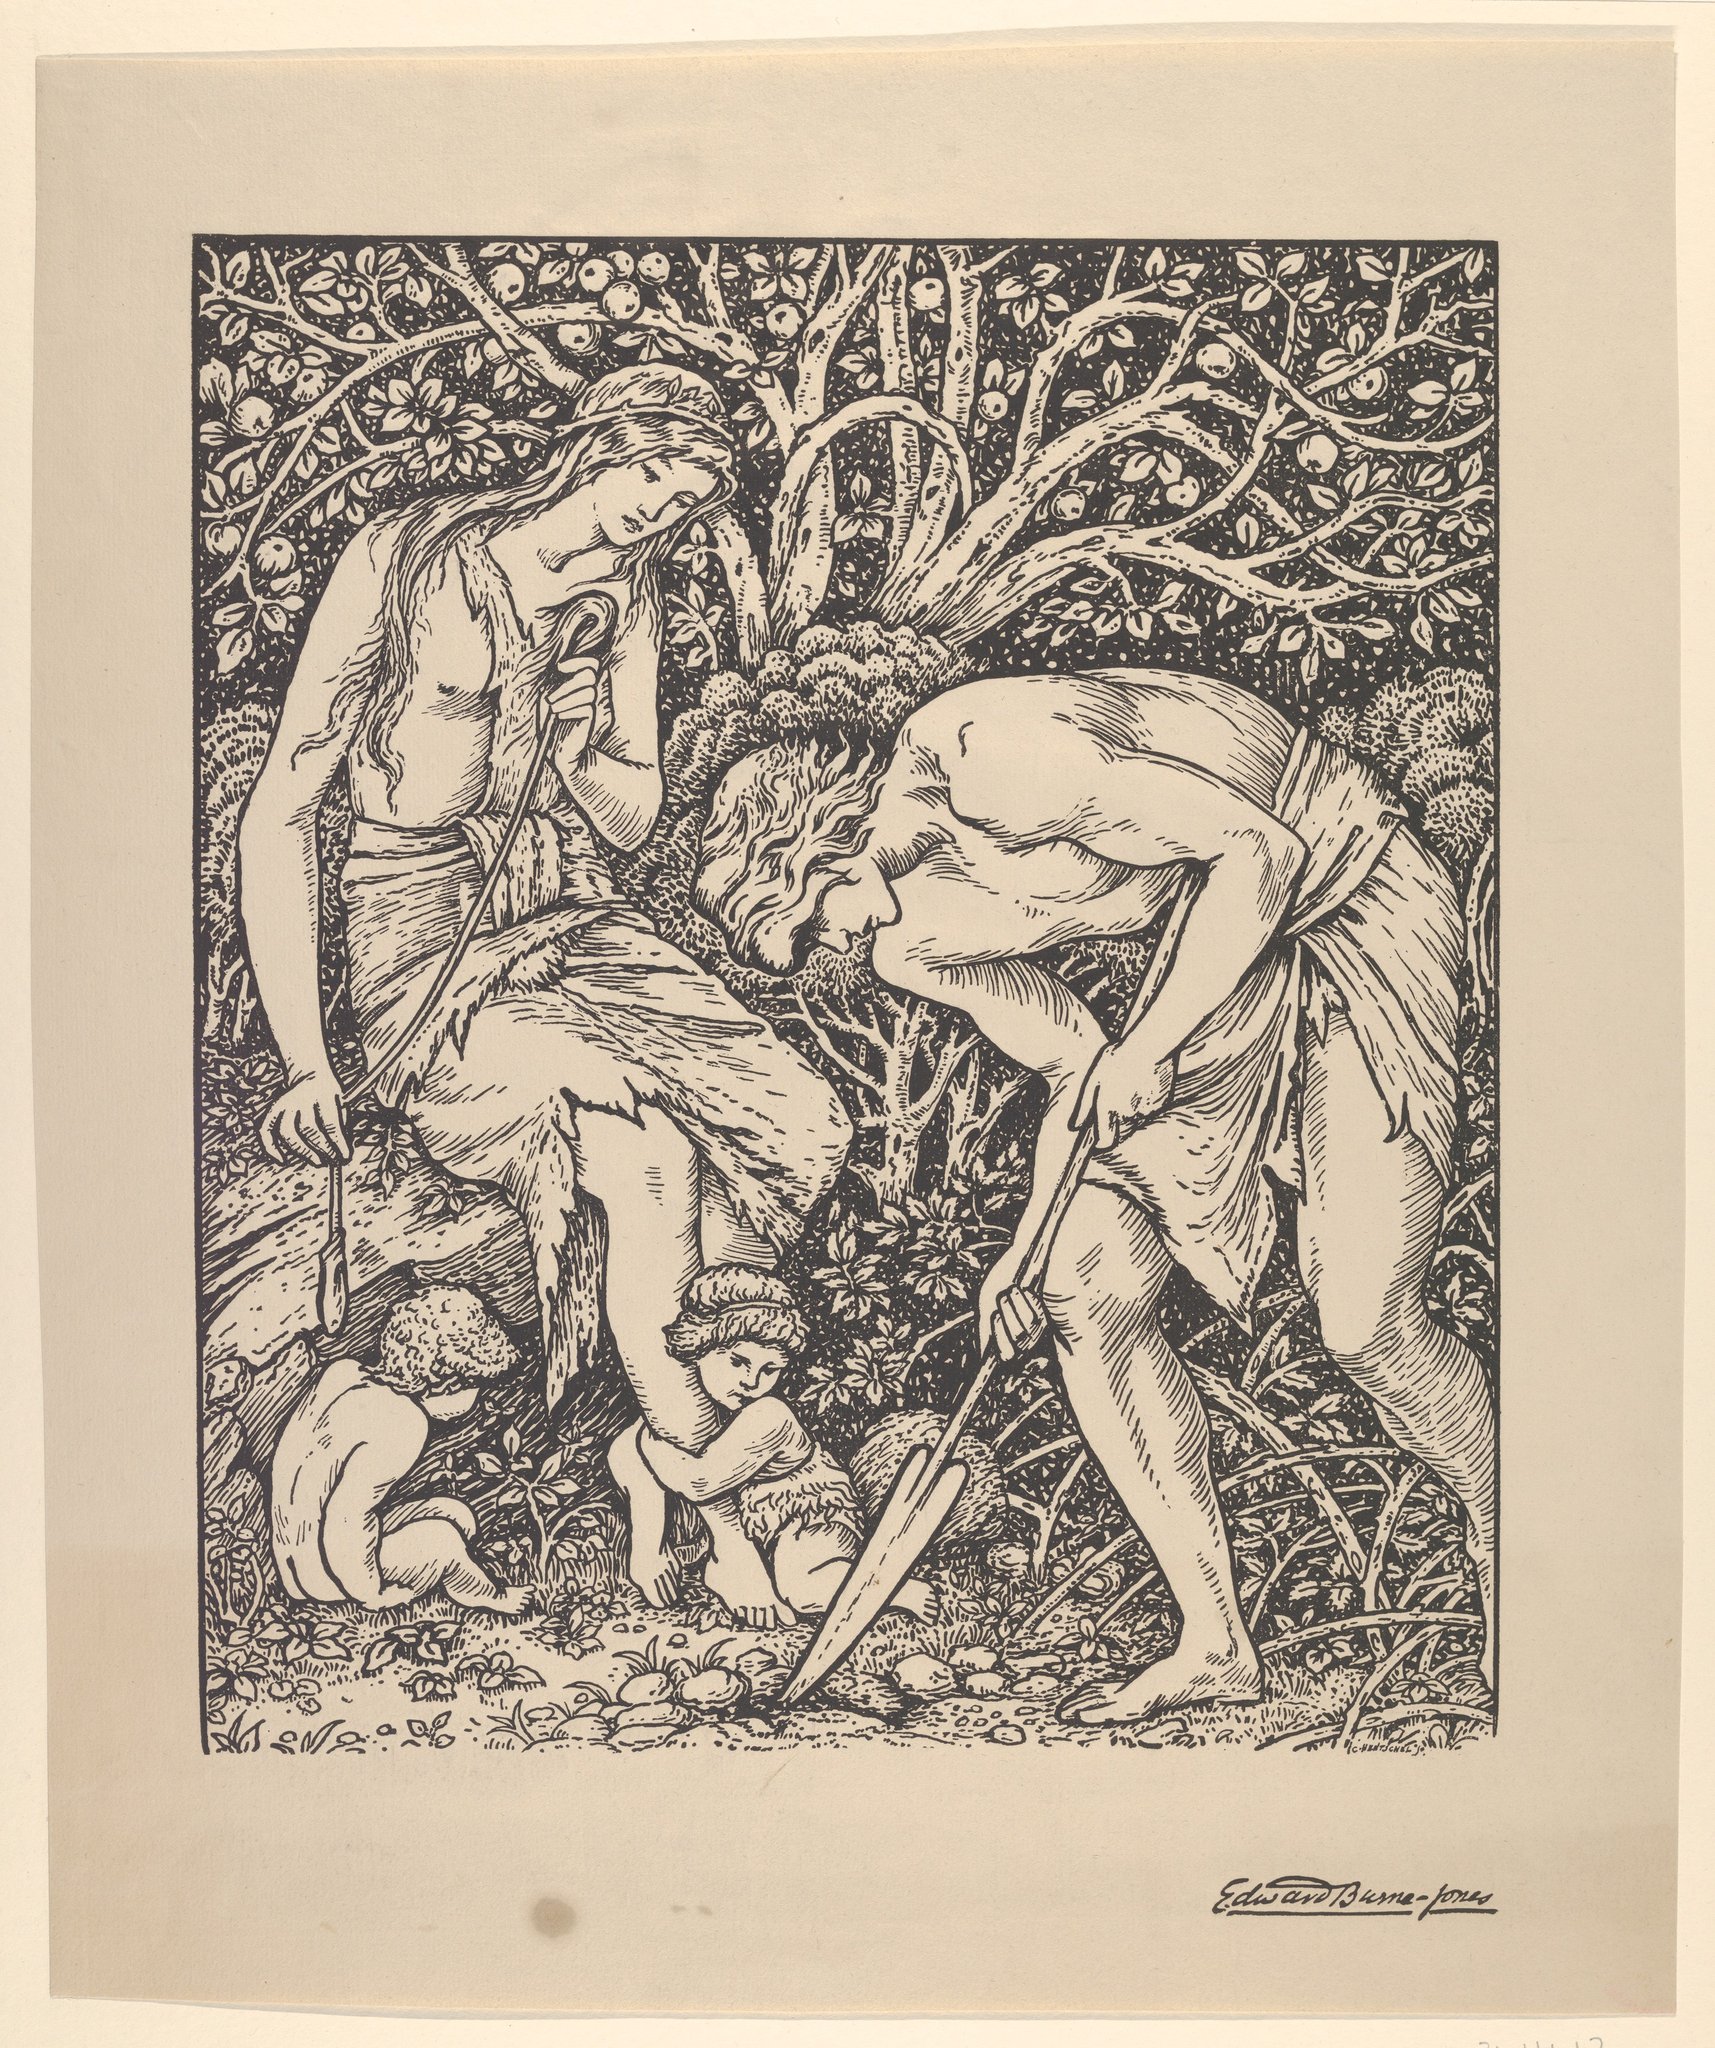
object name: print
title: Adam and Eve (Labour: Whan Adam Delved and Eve Span, Who Was Then the Gentleman?)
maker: sir edward burne-jones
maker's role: artist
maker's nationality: british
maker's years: 1833-1898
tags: infants,trees,adam,eve